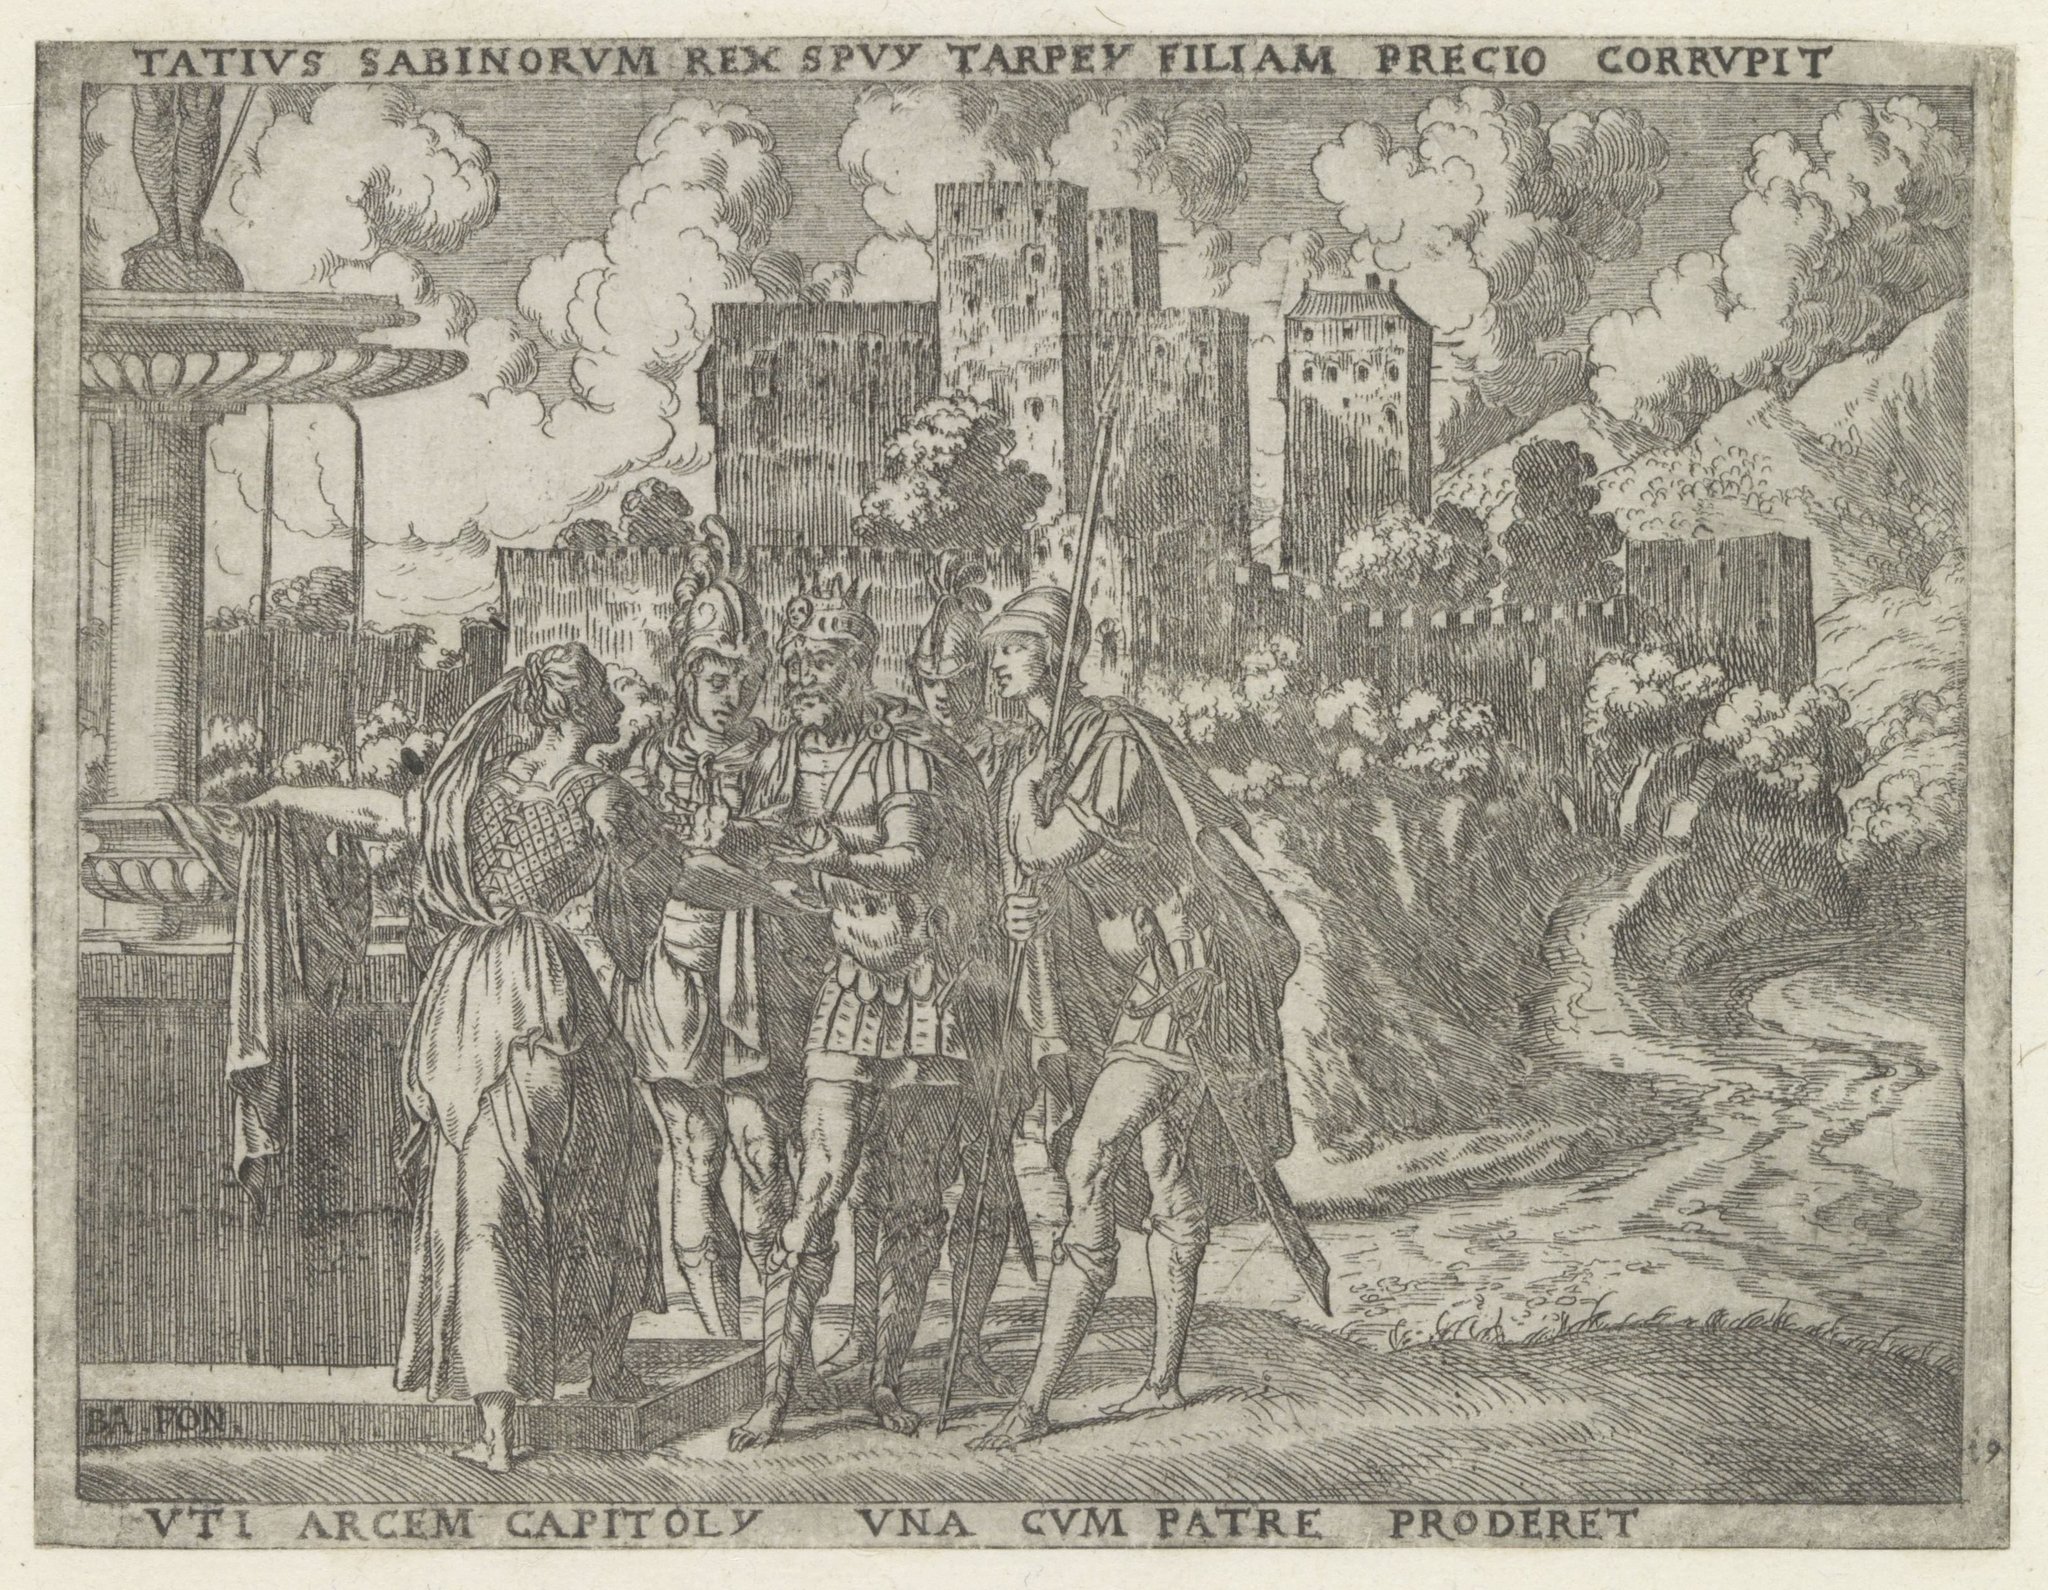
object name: print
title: Tatius sabinorum (...) cum patre proderet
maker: giovanni battista fontana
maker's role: draughtsman, painter, print maker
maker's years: 1524-1587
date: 1572-1573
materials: paper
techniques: etching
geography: italy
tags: while tarpeia is fetching water outside the city-gate she is bribed by titus tatius into opening the gates of the city, (story of) romulus and remus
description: Tarpeia is water aan het halen buiten de stadsmuren. Bij de waterput wordt ze door Titus Tatius overgehaald om de stadspoort te openen. De prent maakt deel uit van een album.